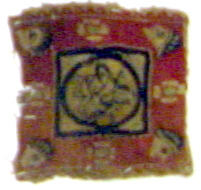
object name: textile fragment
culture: coptic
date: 501-600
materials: linen, wool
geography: egypt